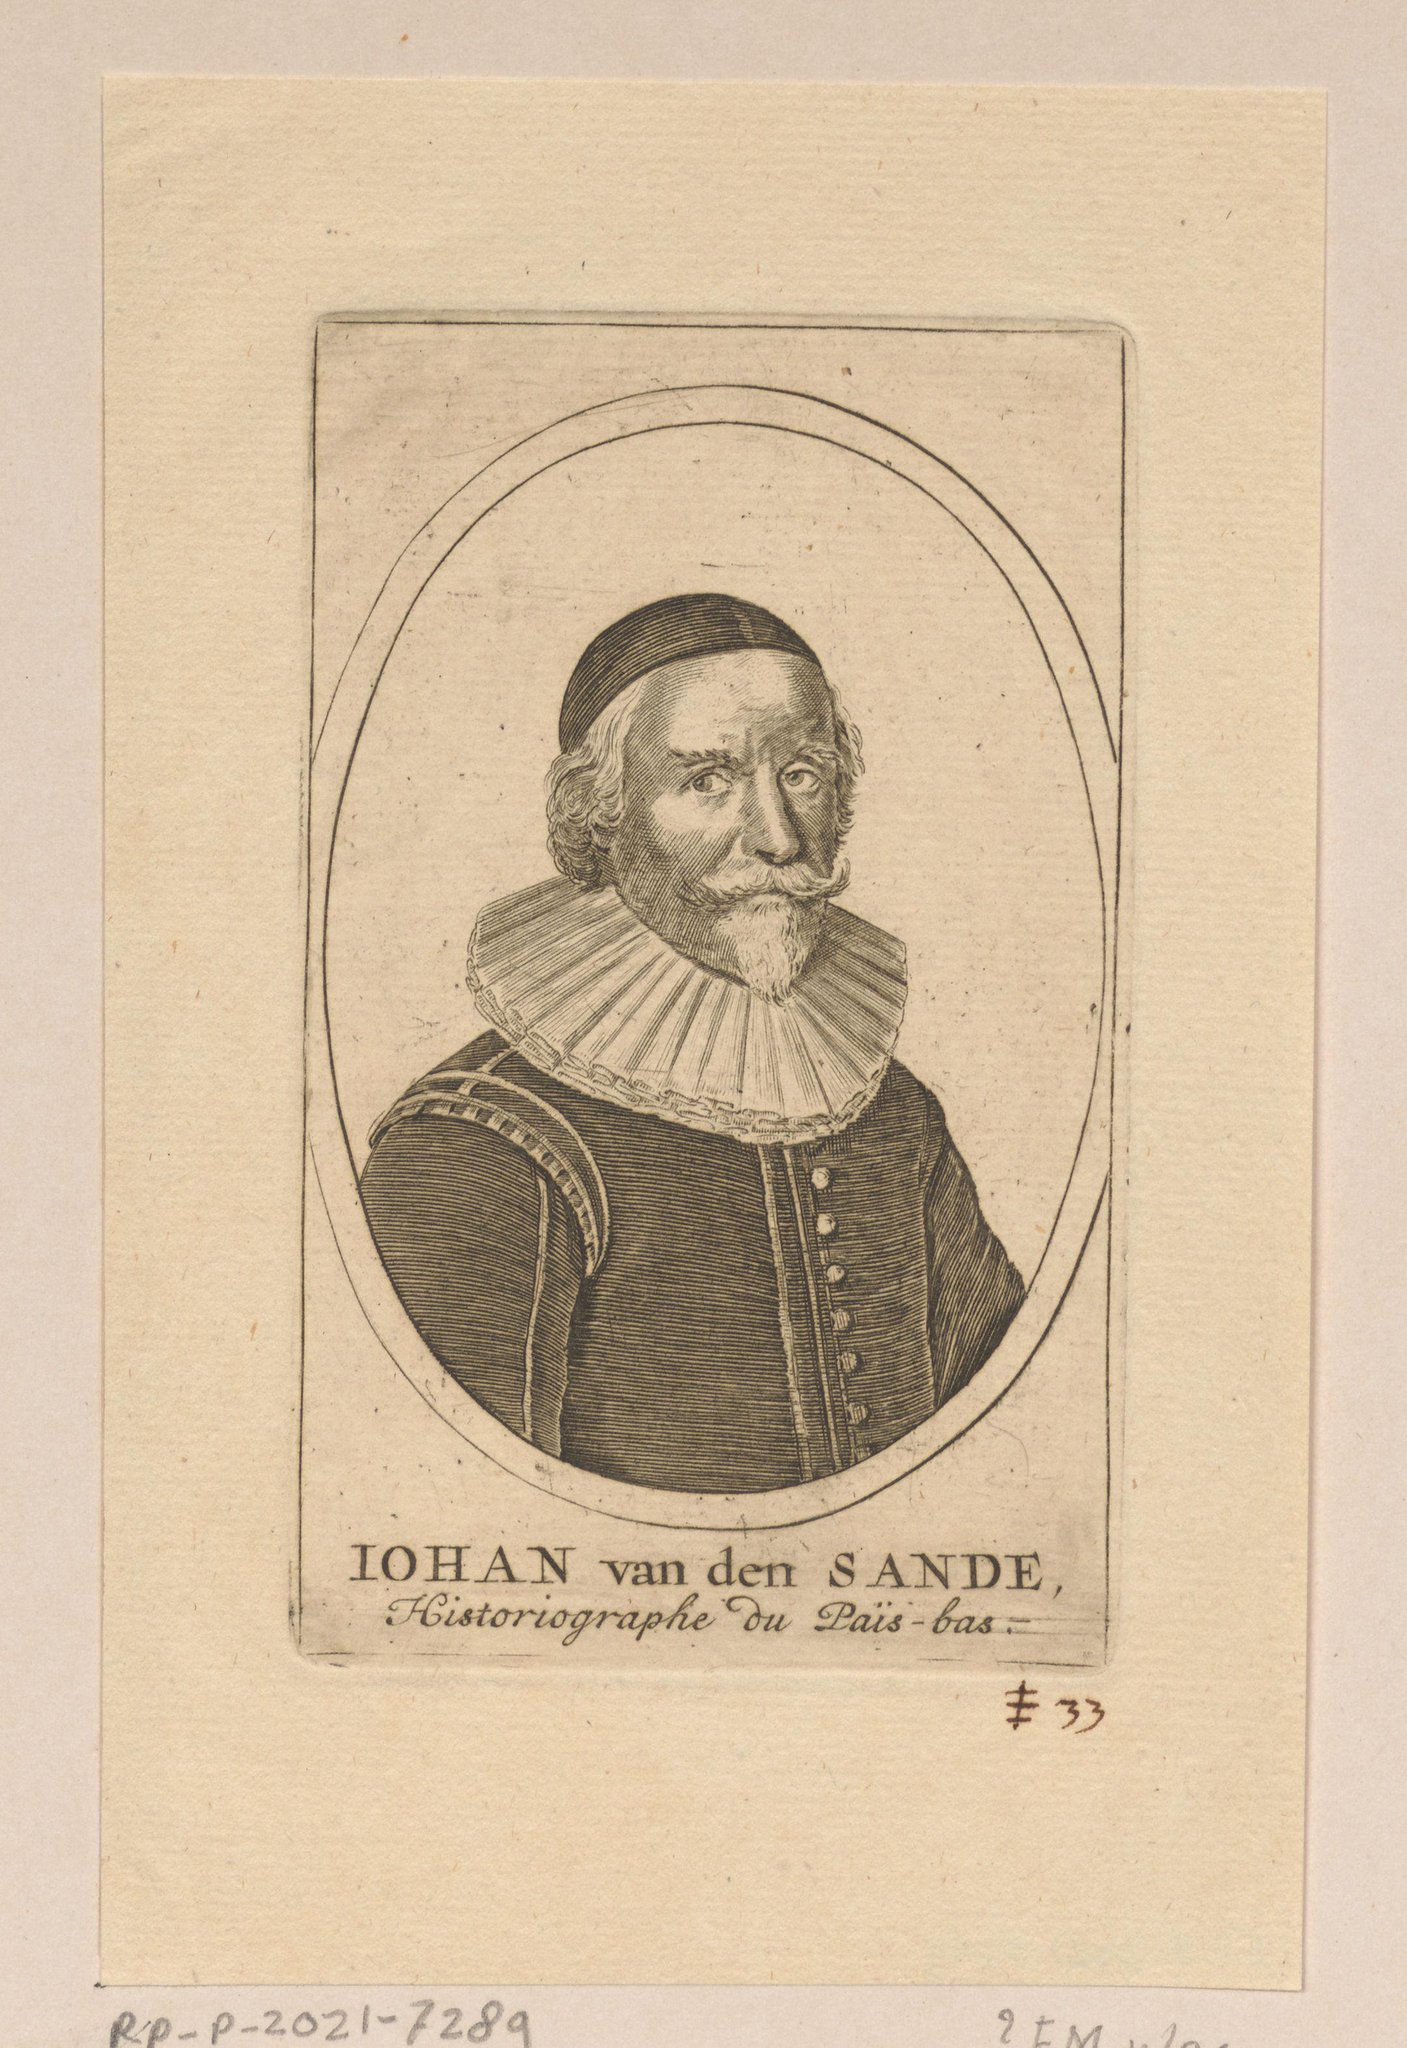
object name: print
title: Portret van Johan van den Sande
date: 1720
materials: paper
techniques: engraving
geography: leiden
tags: arnhem, johan van den sande, historical persons, portrait of a writer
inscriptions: inscription: ‘33’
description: Prent uit: Imagines XLI. Virorum celebriorum in politicis historicis &c. Leiden: Pieter van der Aa, [ca. 1720].